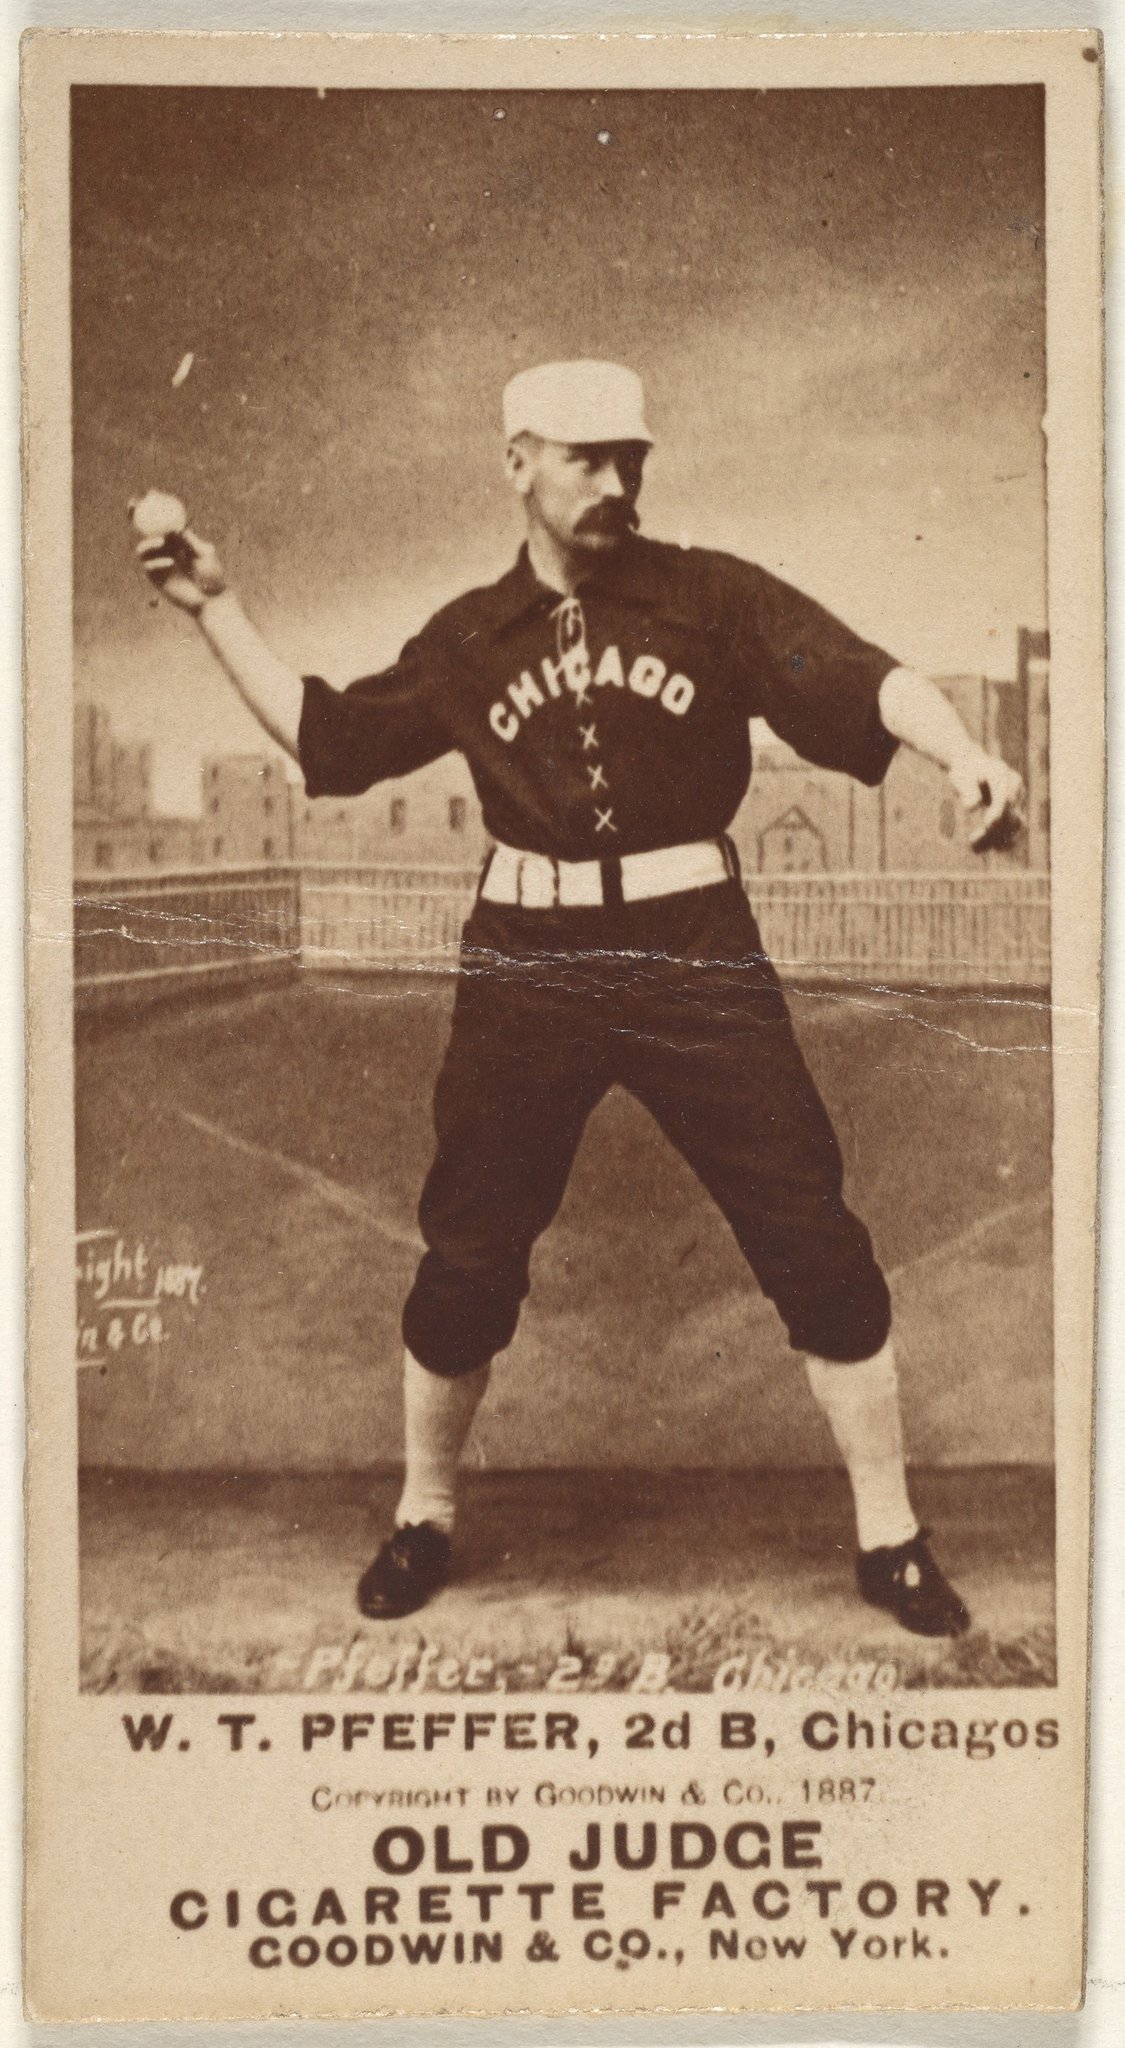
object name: baseball card, photograph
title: Fred "Dandelion" Pfeffer, 2nd Base, Chicago, from the Old Judge series (N172) for Old Judge Cigarettes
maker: goodwin & company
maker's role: publisher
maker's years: 1850-1950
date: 1887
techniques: albumen silver print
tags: men,portraits,baseball,athletes